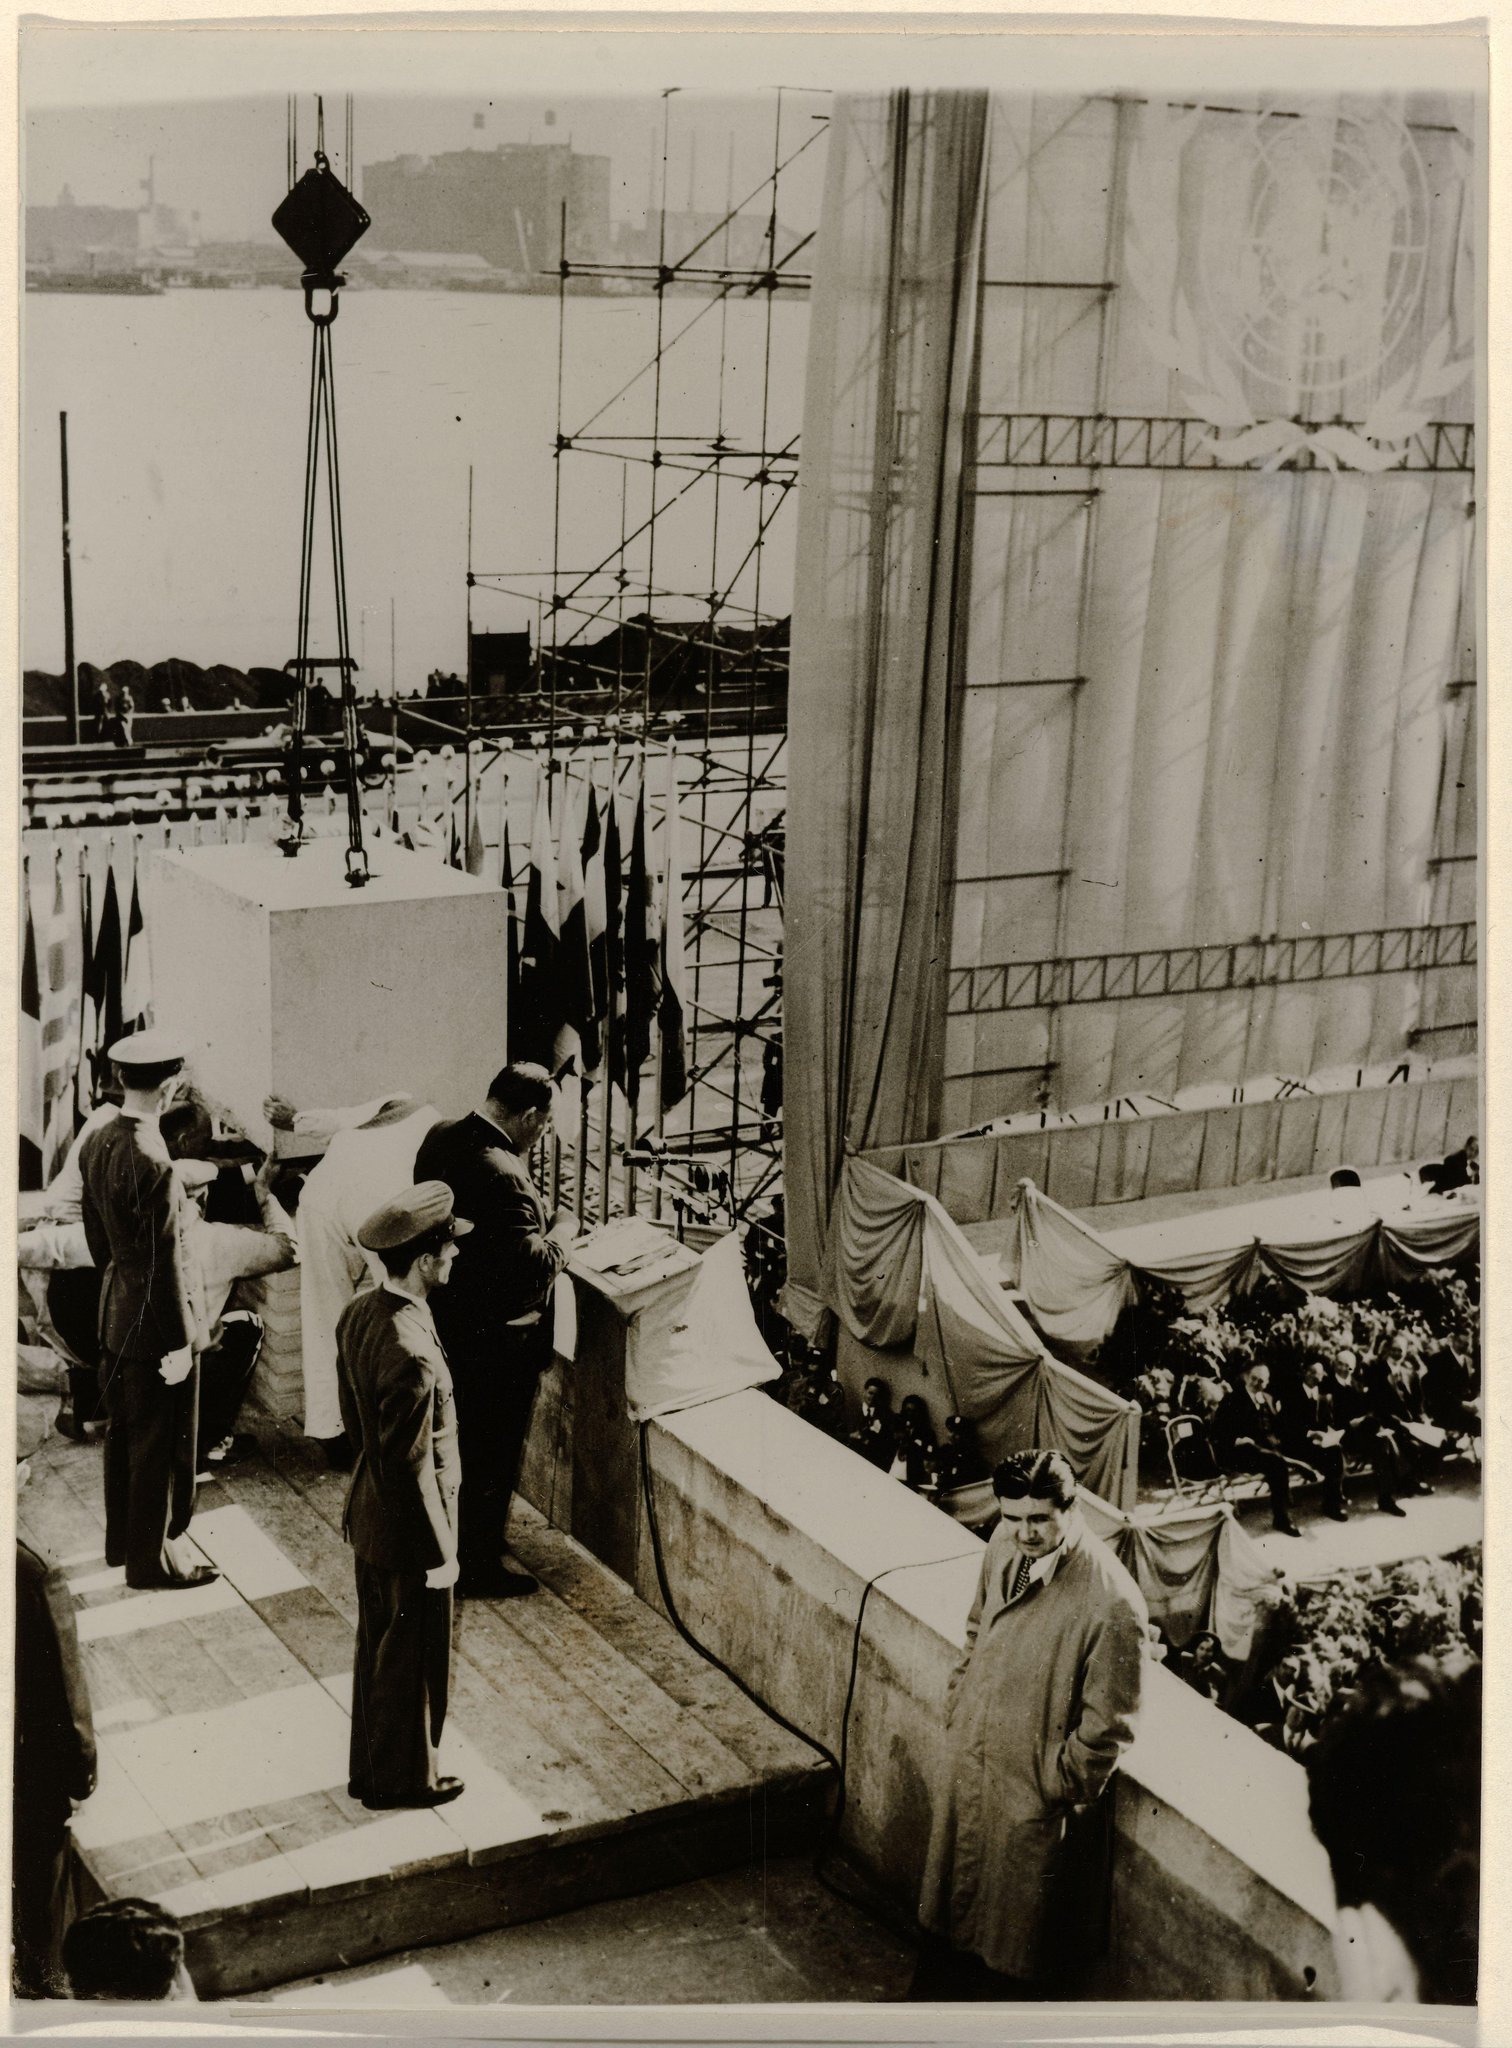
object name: photograph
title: United Nations corner-stone laid at organisation's permanent headquarters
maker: Anonymous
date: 1949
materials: paper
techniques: gelatin silver print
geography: london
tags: politician, address, talk, lecture (~ meeting) - aa - in the open air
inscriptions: inscription: ‘KEYSTONE/ 219 EAST 4th STREET,/ NEW YORK/ N.Y./ RED LION COURT,/ FLEET STREET,/ LONDON/ E.C.4.’, inscription: ‘About 10,000 people, including delegates to the/ United Nations, attended the dedication of the/ World organisation's permanent headquarters in the/ centre of New York. The corner-stone of the new/ building was laid by M. Lie, the Secretary-General/ and Mr. Truman was the principal speaker at the/ ceremony./ PHOTO SHOWS/ Secretary-General Trygve Lie making/ an address before laying the corner-/ stone. Inside the cavity of the Stone/ he placed a copy of the United Nations/ Charter./ 1/J. Keystone. 1/552792.’, copyright notice: ‘COPYRIGHT/ PHOTO PRESS BELGIUM S.A./ 108, Avenue de France, Anvers - Tél. 237.71/ 23, rue des Sables, Bruxelles - Tél. 18.33.27/ C. Ch. Postaux 96.49 - R.C.A. 166.717’